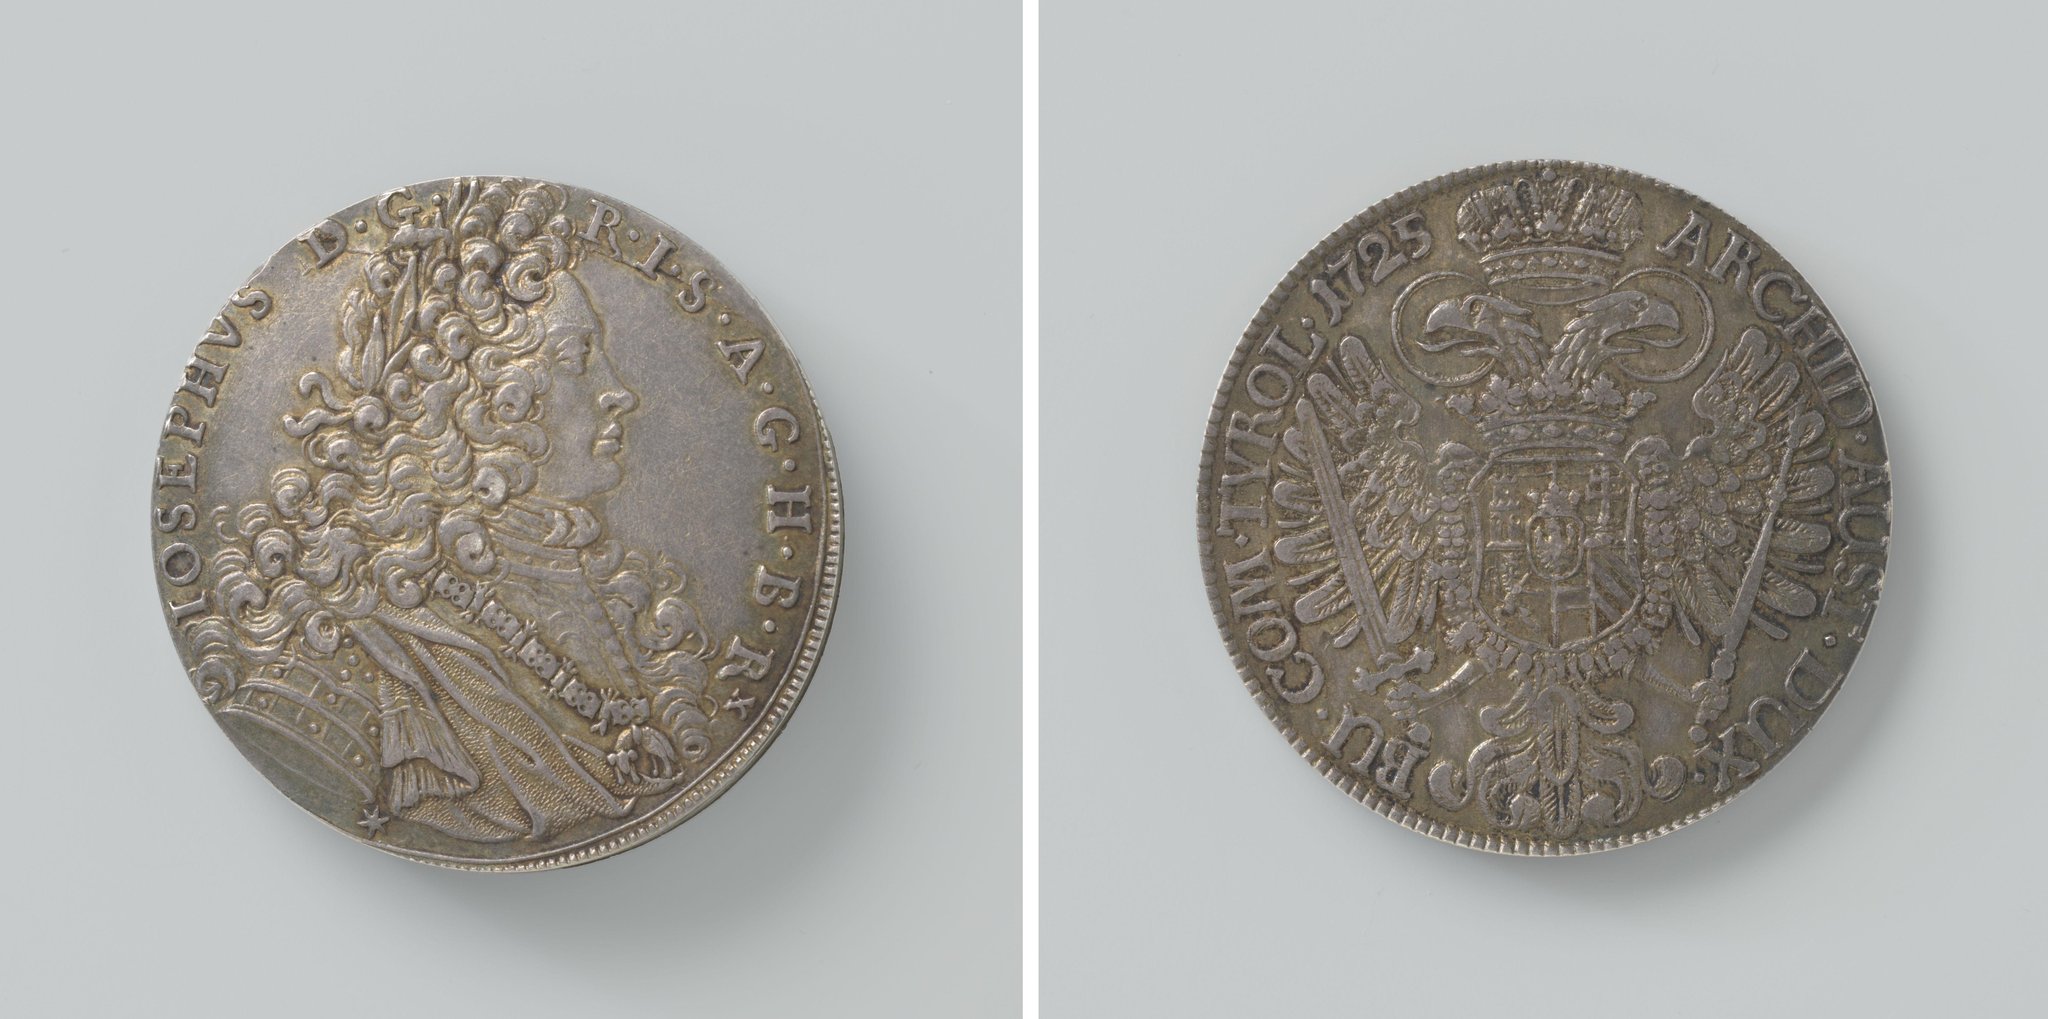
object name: schroefdaalder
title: Schroefdaalder met aankleedplaatjes, bestaande uit de voorzijde van een taler met het portret van aartshertog Jozef I en de keerzijde van een andere taler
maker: Anonymous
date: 1725-1750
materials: paint, silver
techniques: striking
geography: munich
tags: vienna, jozef i (duits keizer)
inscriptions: circumscription: ‘ARCHID.AUST.DUX / BU.COM.TYROL.1725’, circumscription: ‘IOSEPHVS D.R.I.S.A.G.H.B.Rx’